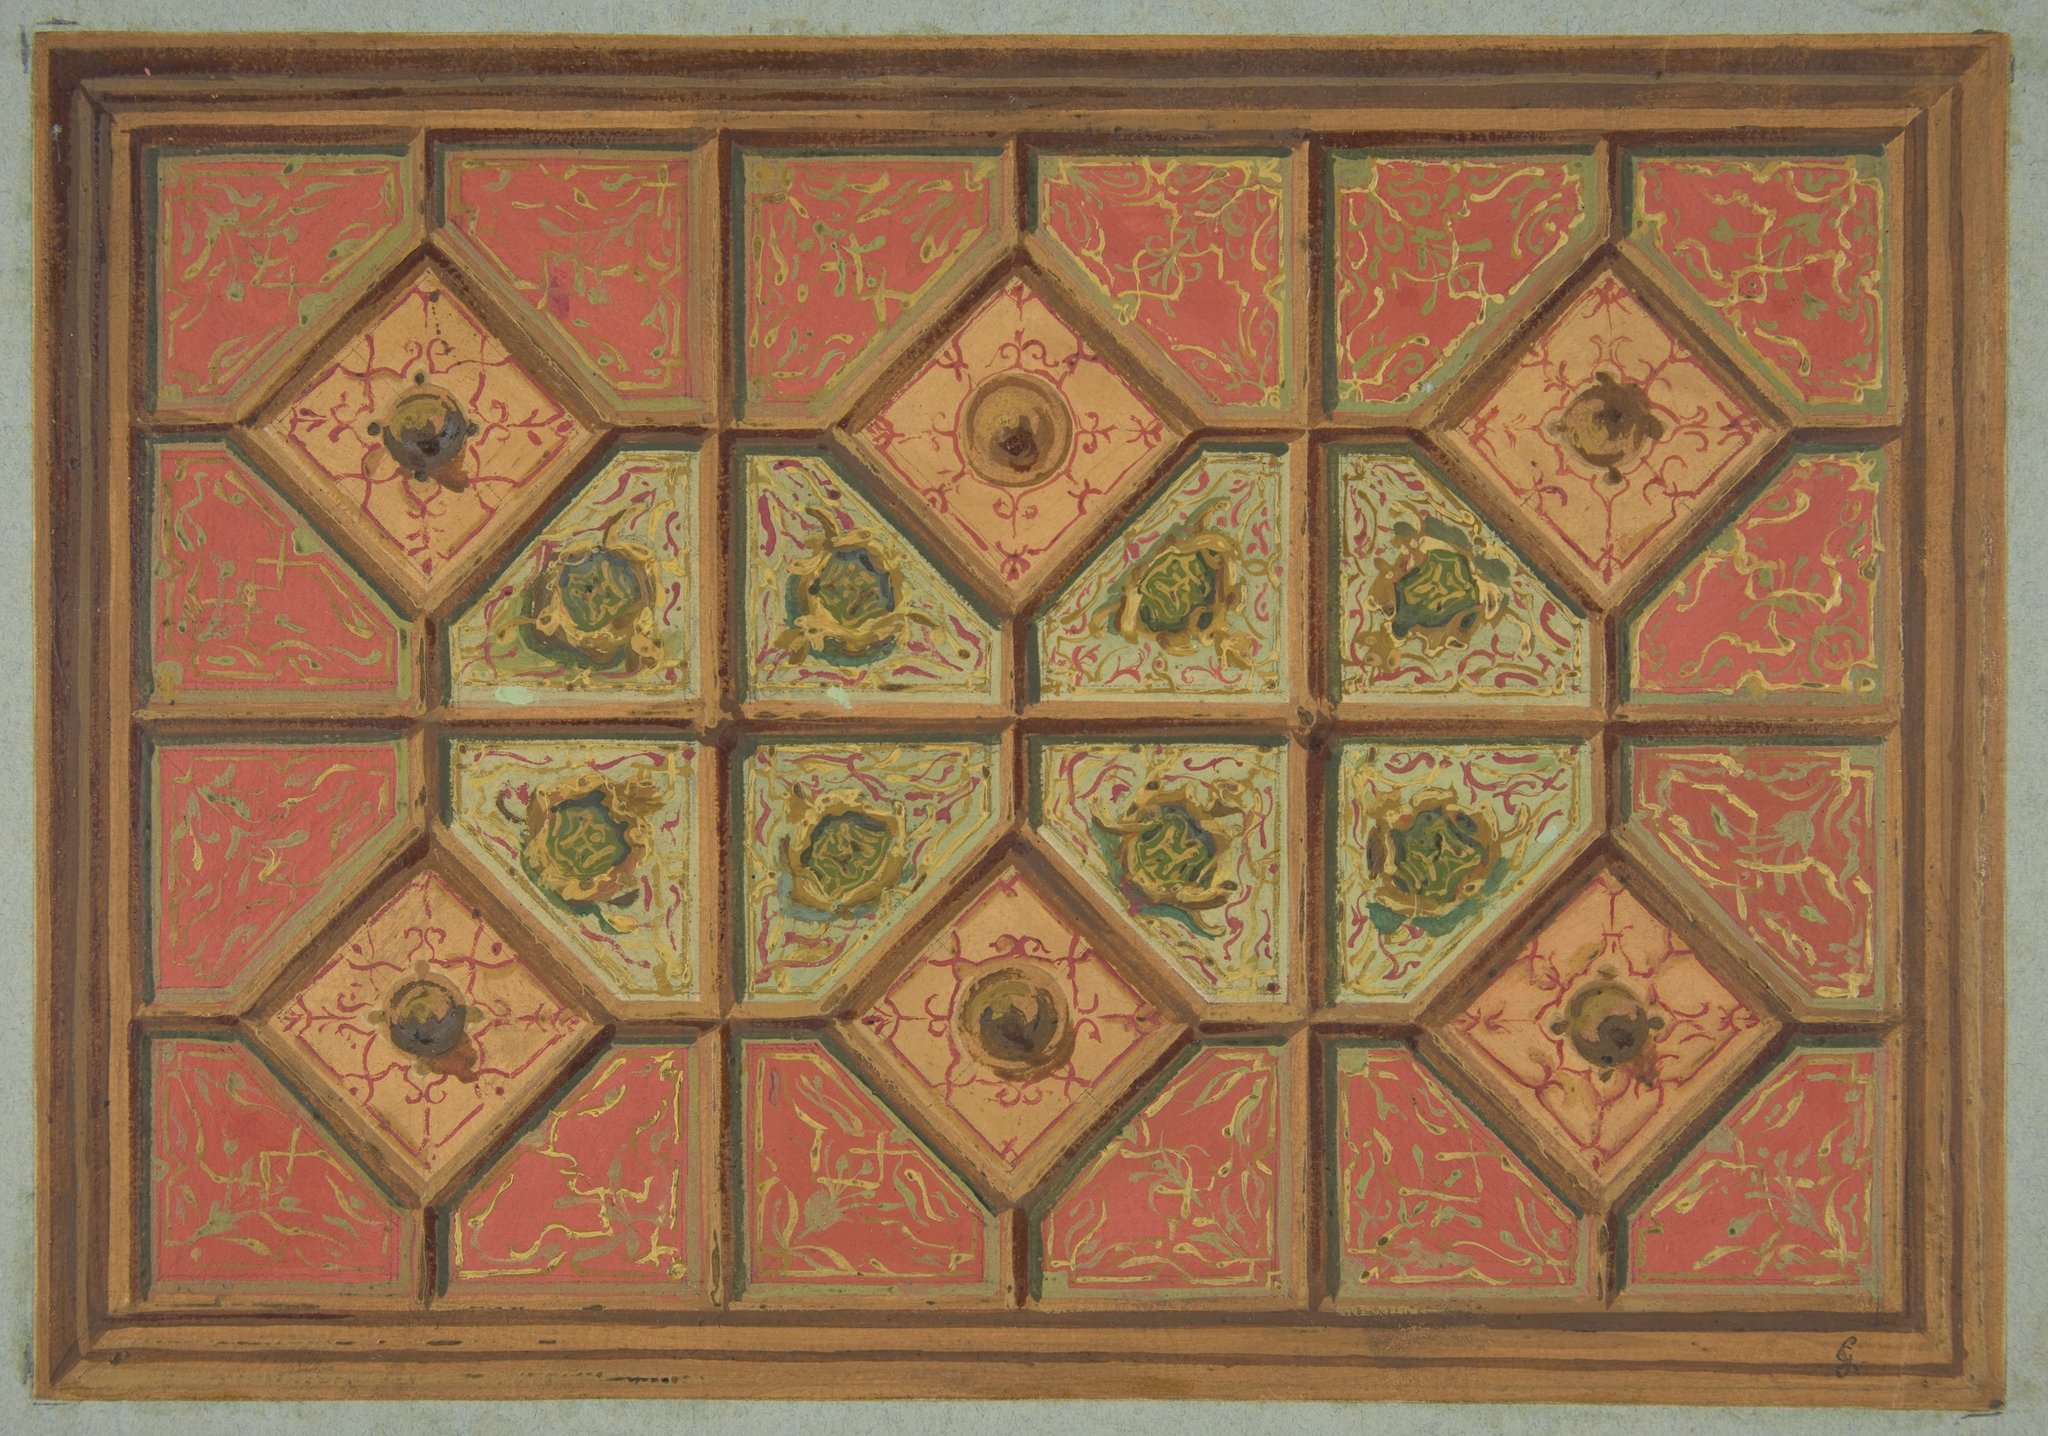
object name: drawing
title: Design for the painted decoration of a coffered ceiling incorporating the initial: H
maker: jules-edmond-charles lachaise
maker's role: artist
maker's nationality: french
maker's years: 1897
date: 1830-1897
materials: gouache, paper, oil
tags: insignia